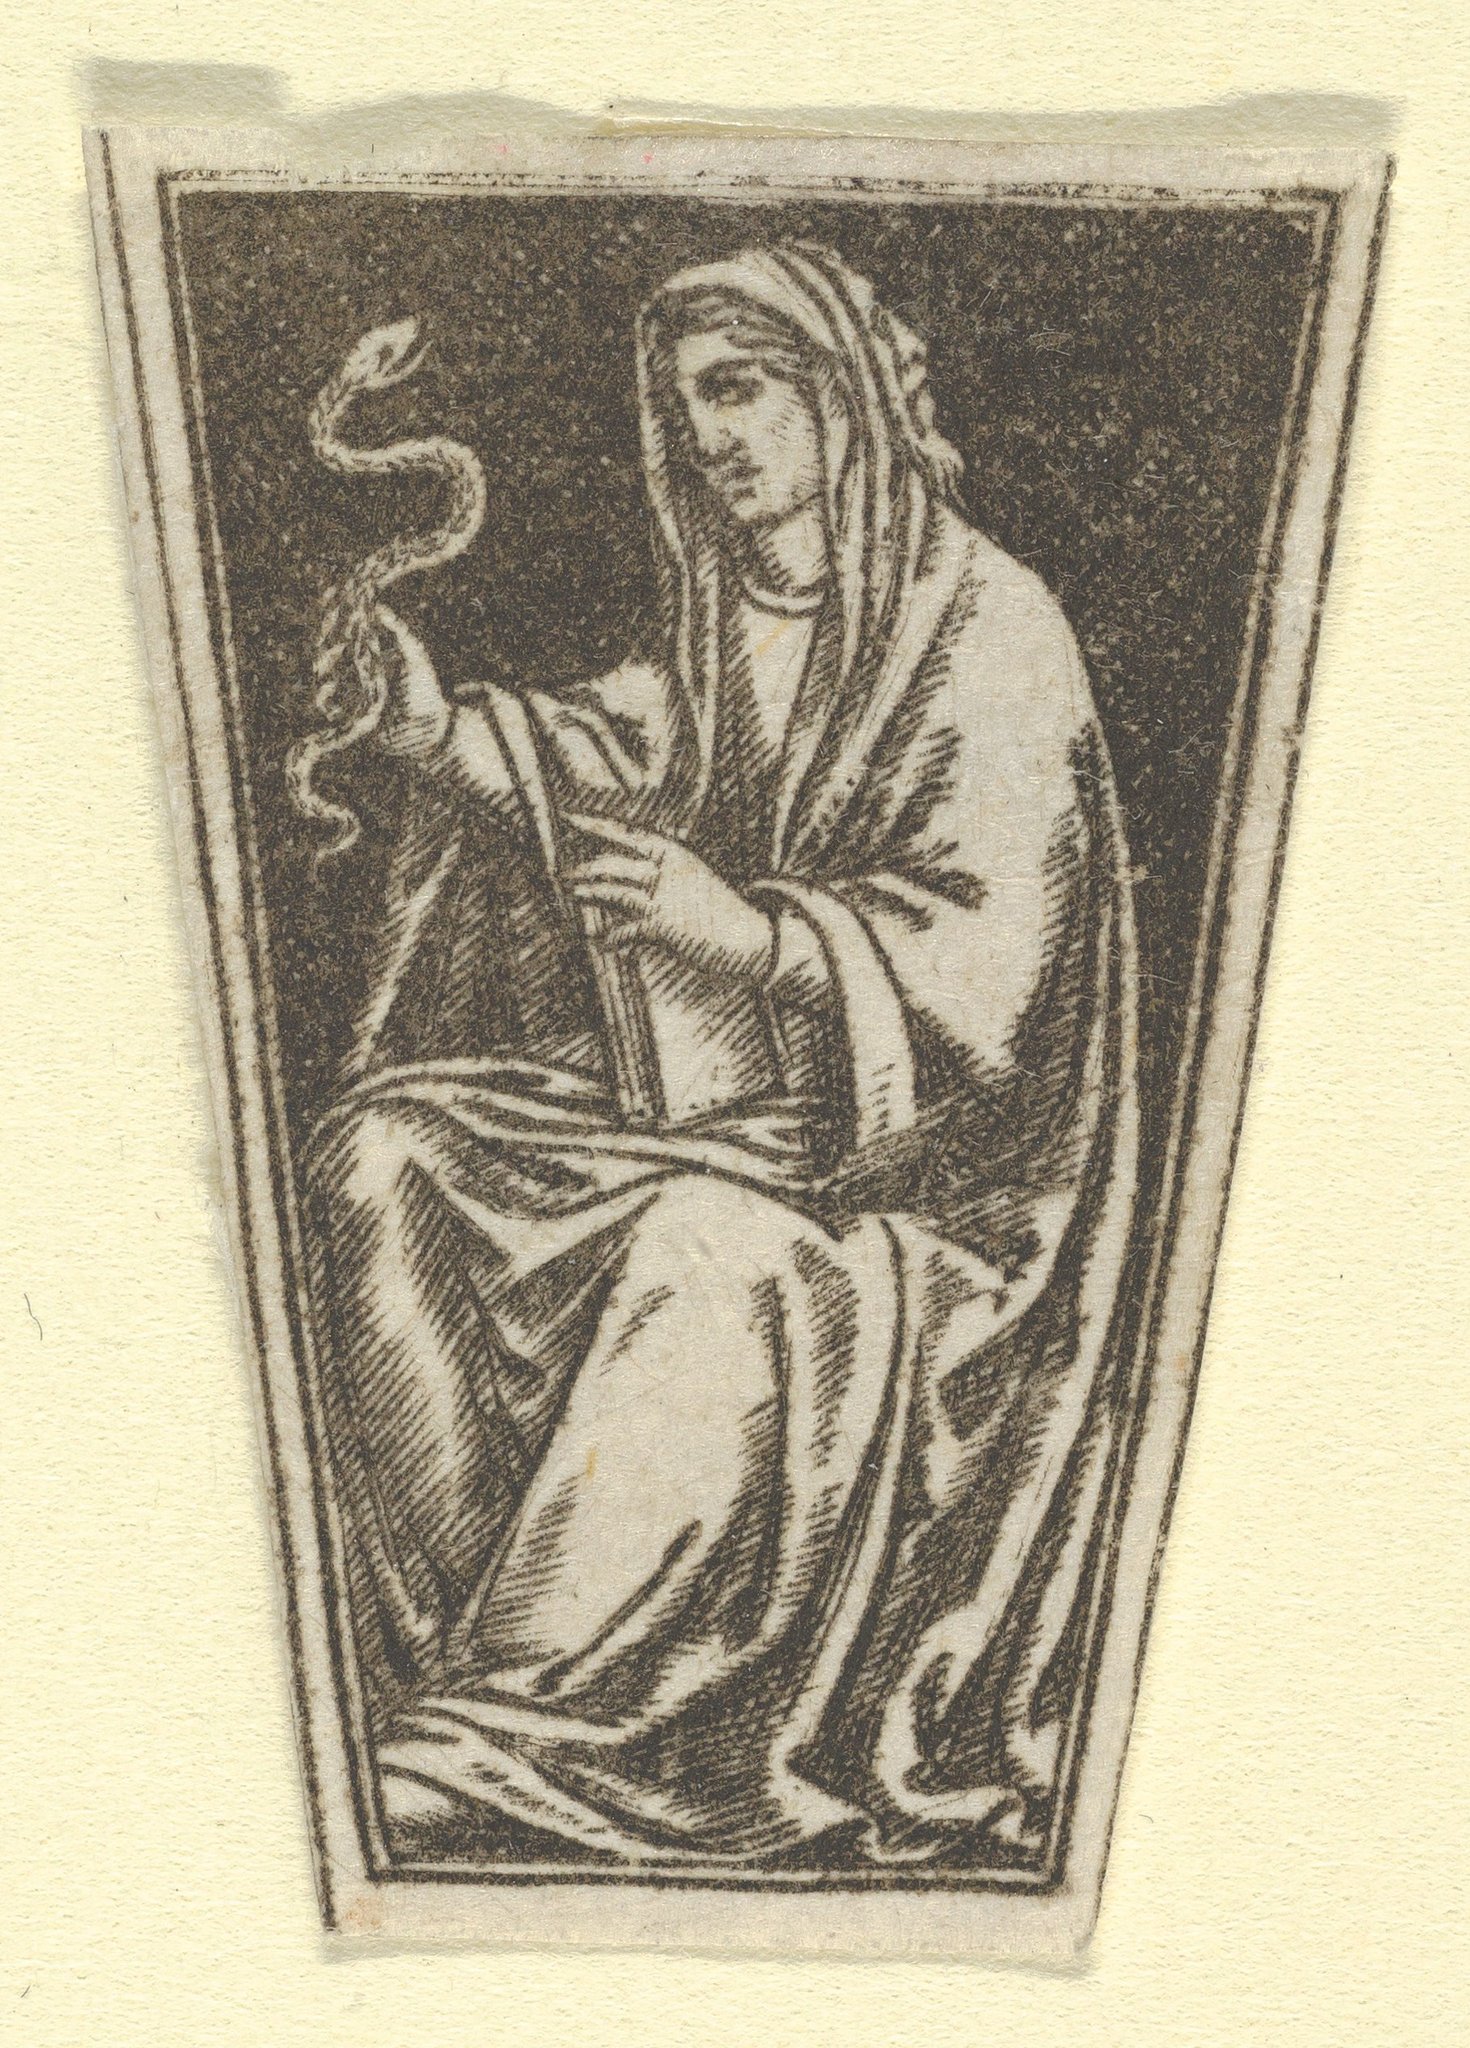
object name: print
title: The cardinal virtue of Prudence represented by a seated woman holding a snake in her right hand (possibly a modern impression)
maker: Anonymous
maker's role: artist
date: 1480-1520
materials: niello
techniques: engraving, printing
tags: women,snakes